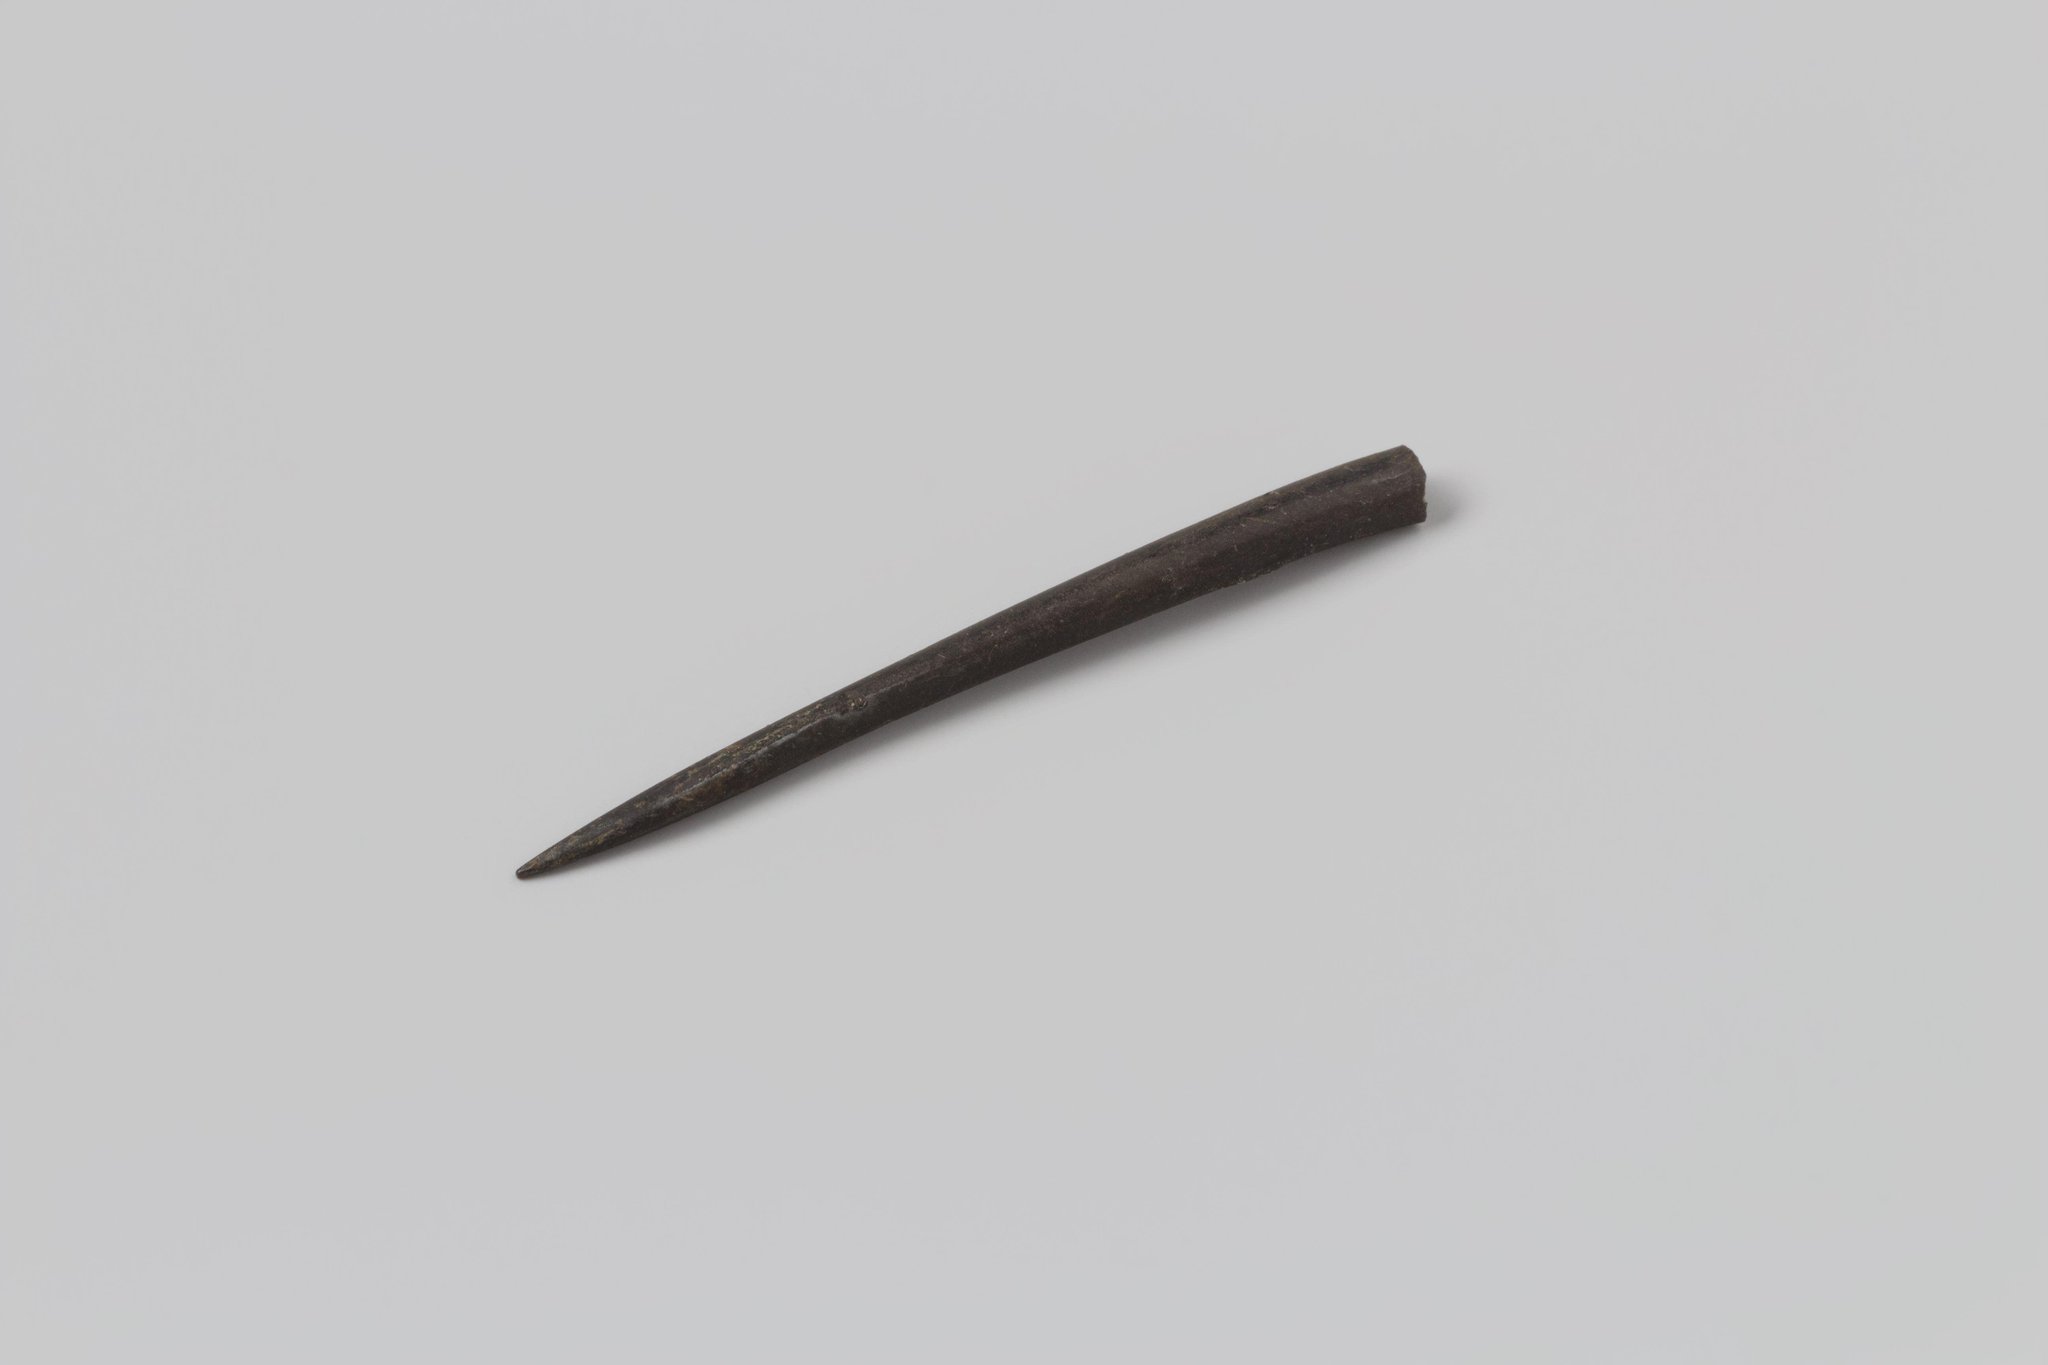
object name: fork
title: Tand van een vork uit het wrak van de Oost-Indiëvaarder Hollandia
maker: Anonymous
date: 1700-1743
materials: copper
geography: netherlands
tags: verenigde oostindische compagnie, hollandia (schip), annet